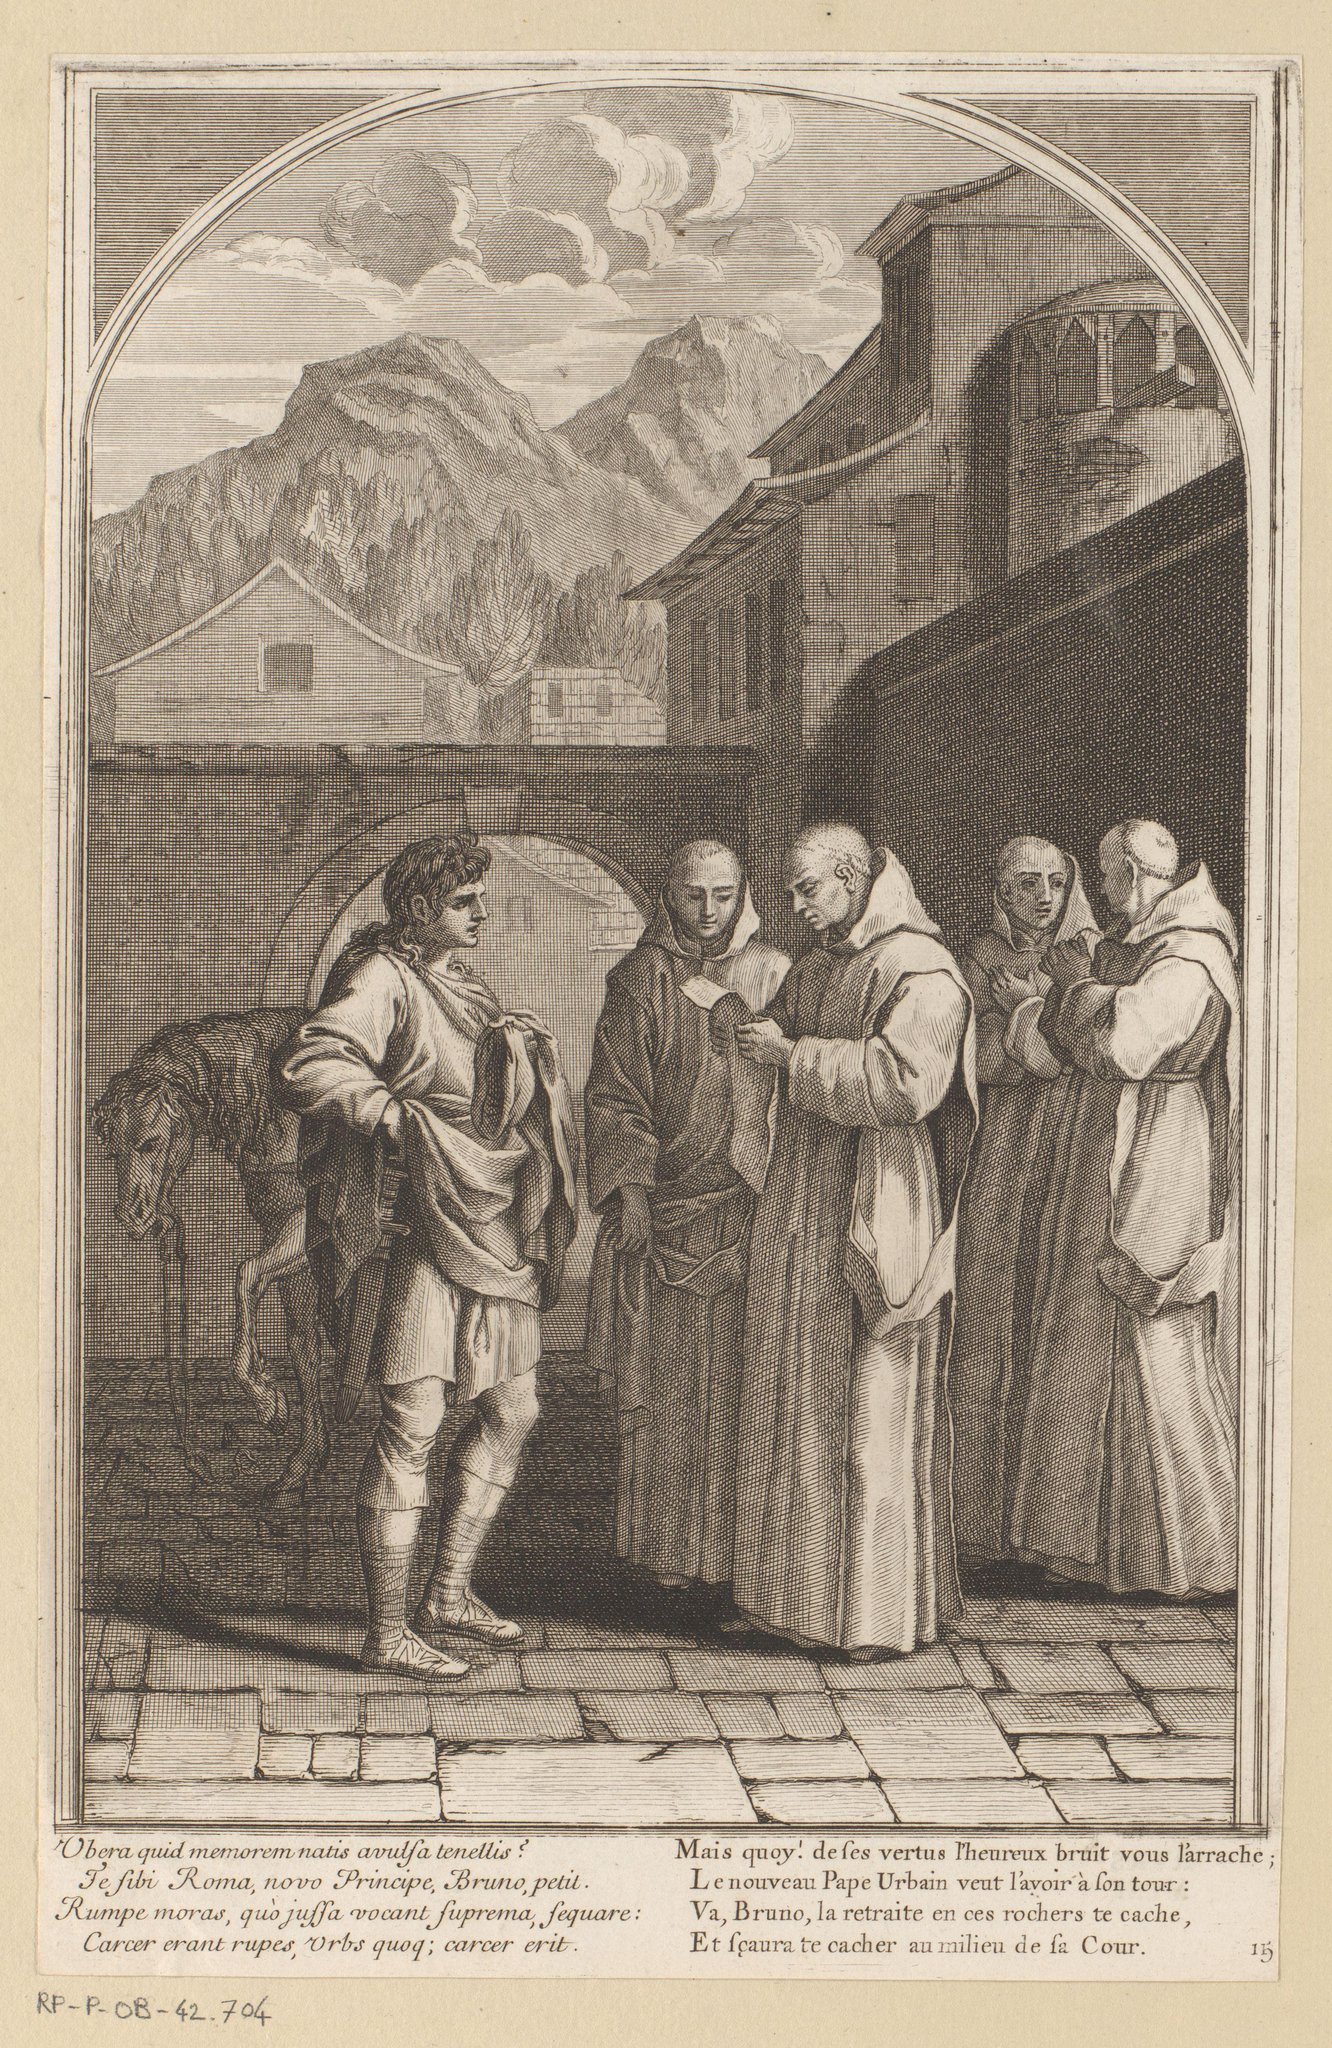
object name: print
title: La vie de St. Bruno (...)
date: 1647-1714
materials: paper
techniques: engraving, etching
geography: paris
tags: the founder of the order of the carthusians, bruno; possible attributes: cross, finger at lips, lily, mitre at his feet, olive-branch, ray of light, skull, (seven) star(s)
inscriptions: collector's mark: Lugt 2165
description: Maakt deel uit van een serie met 24 prenten (inclusief twee titelprenten), naar schilderijen door Lesueur vervaardigd tussen 1645-1648 voor de Chartreuse de Paris. De serie is getiteld: La vie de St. Bruno fondateur de l'Ordre des Chartreux peinte au cloistre de la Chartreuse de Paris par Eustache Le Sueur.